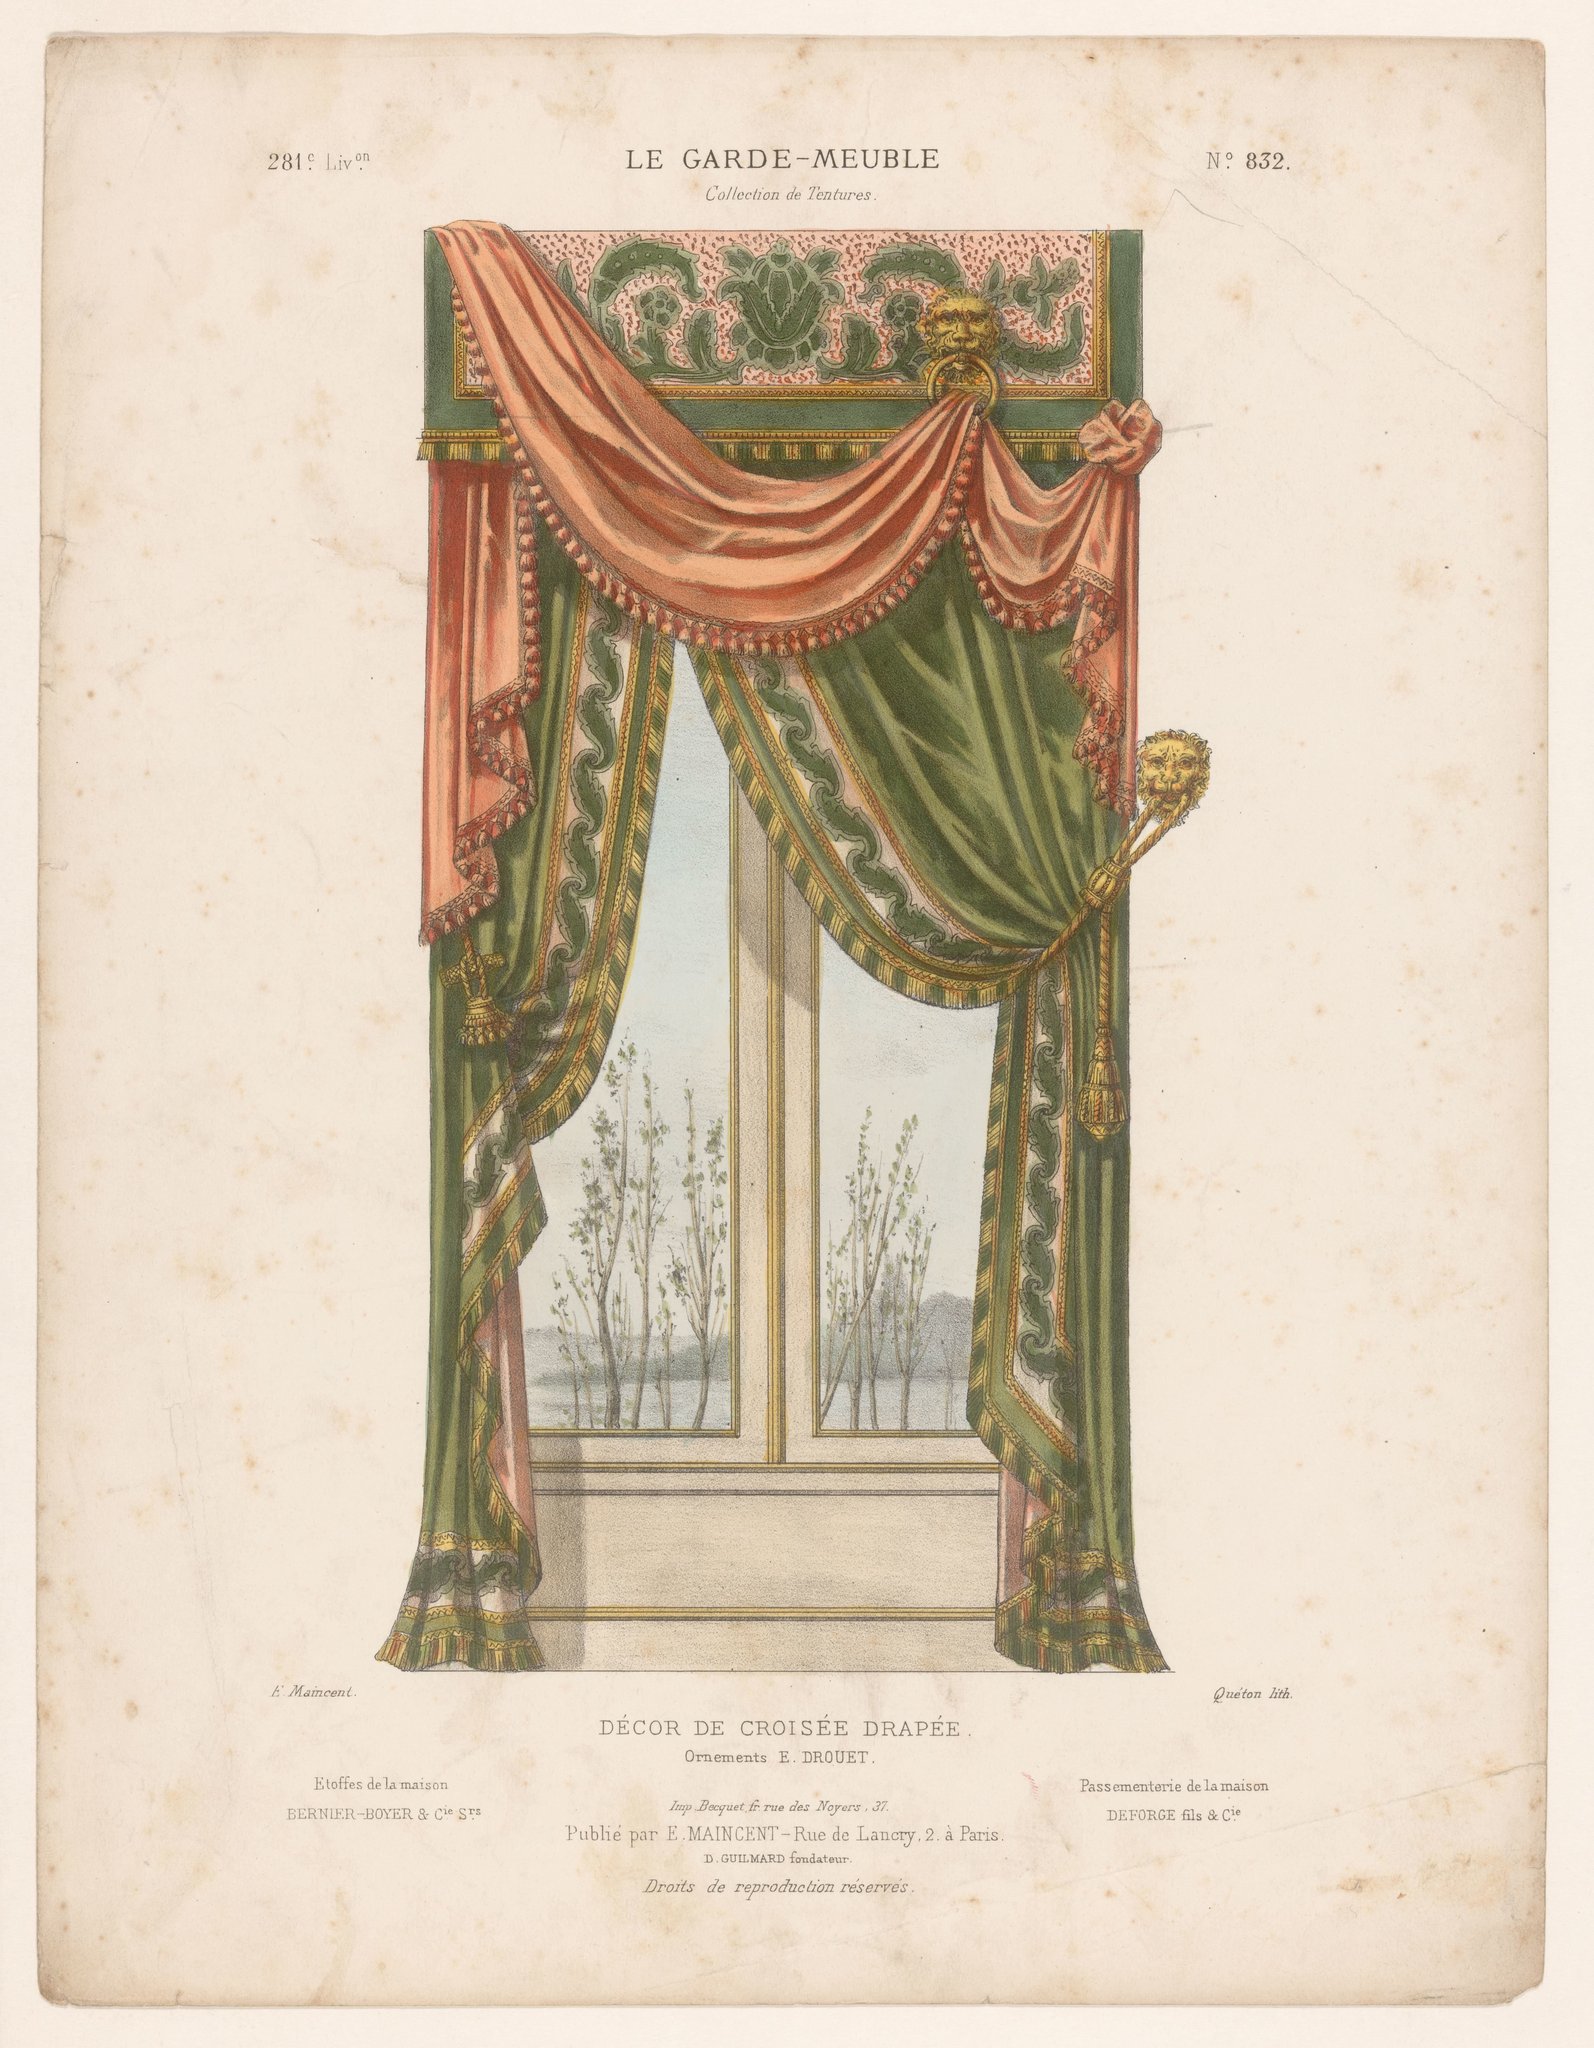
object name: print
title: Venster met gordijnen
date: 1885-1895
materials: paper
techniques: hand coloring, lithograph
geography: paris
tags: window, hangings and drapery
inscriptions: : ‘Droits de reproduction réservés.’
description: Kruisvenster met gedrapeerde gordijnen. Prent uit 281e Livraison.